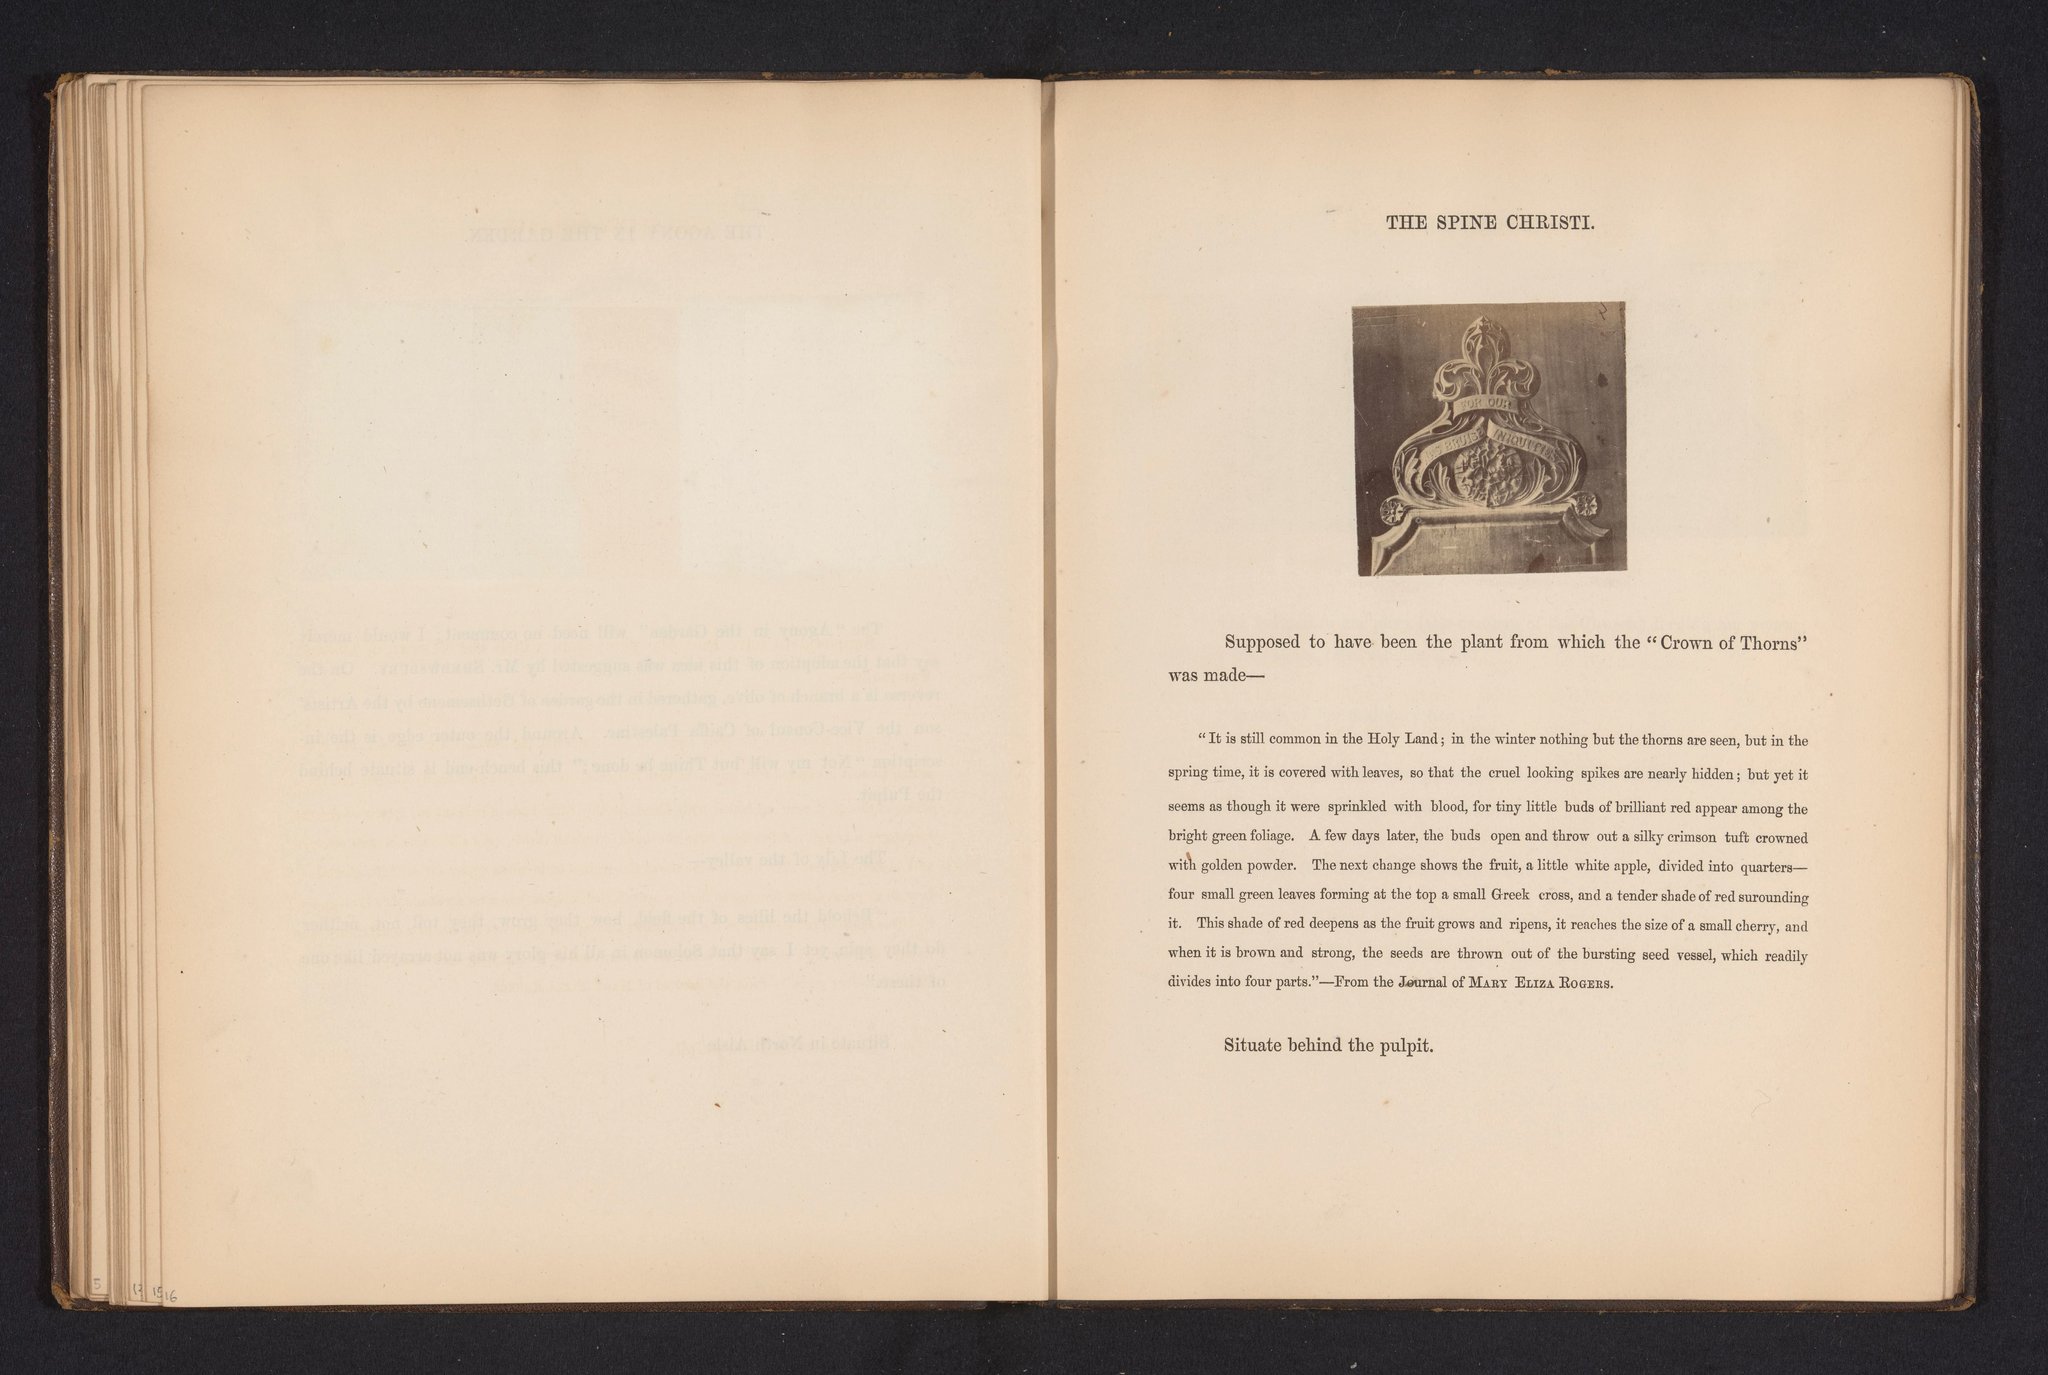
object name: photograph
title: Decoratie van een kerkbank in de St Michael in Cornhill, voorstellend een echte christusdoorn met de tekst: For our iniquities he was bruised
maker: Anonymous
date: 1857-1867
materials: photographic support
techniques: albumen print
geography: st michael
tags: bench, crown of thorns ~ instruments of the passion